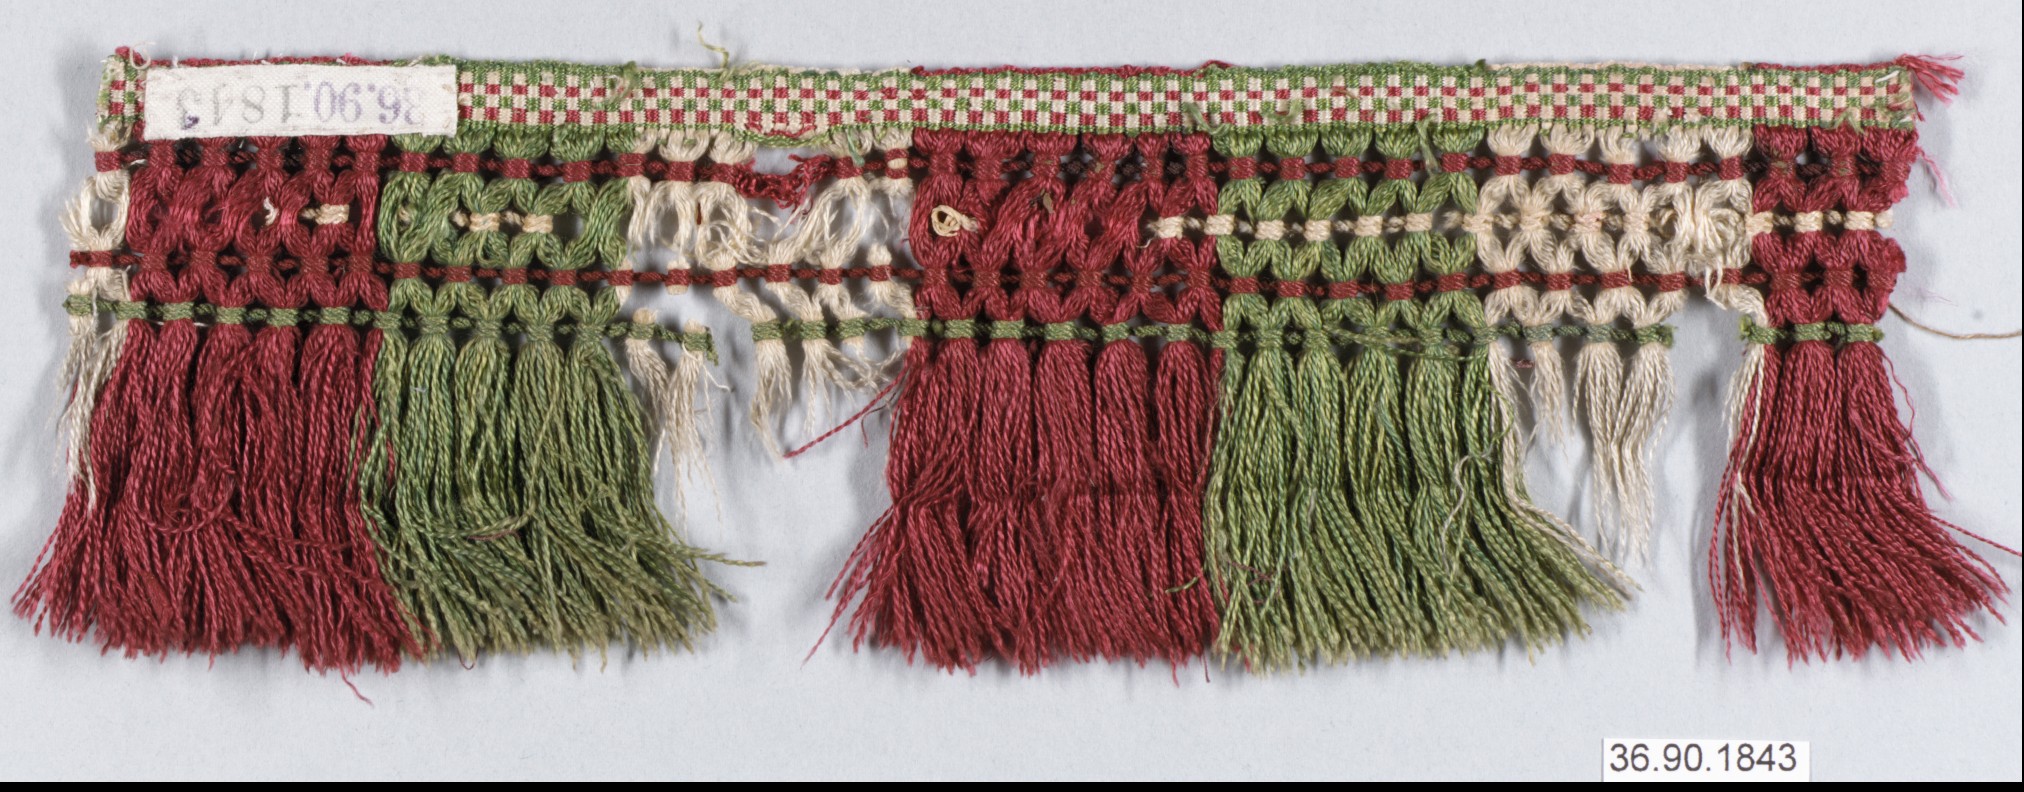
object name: fringe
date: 1767-1800